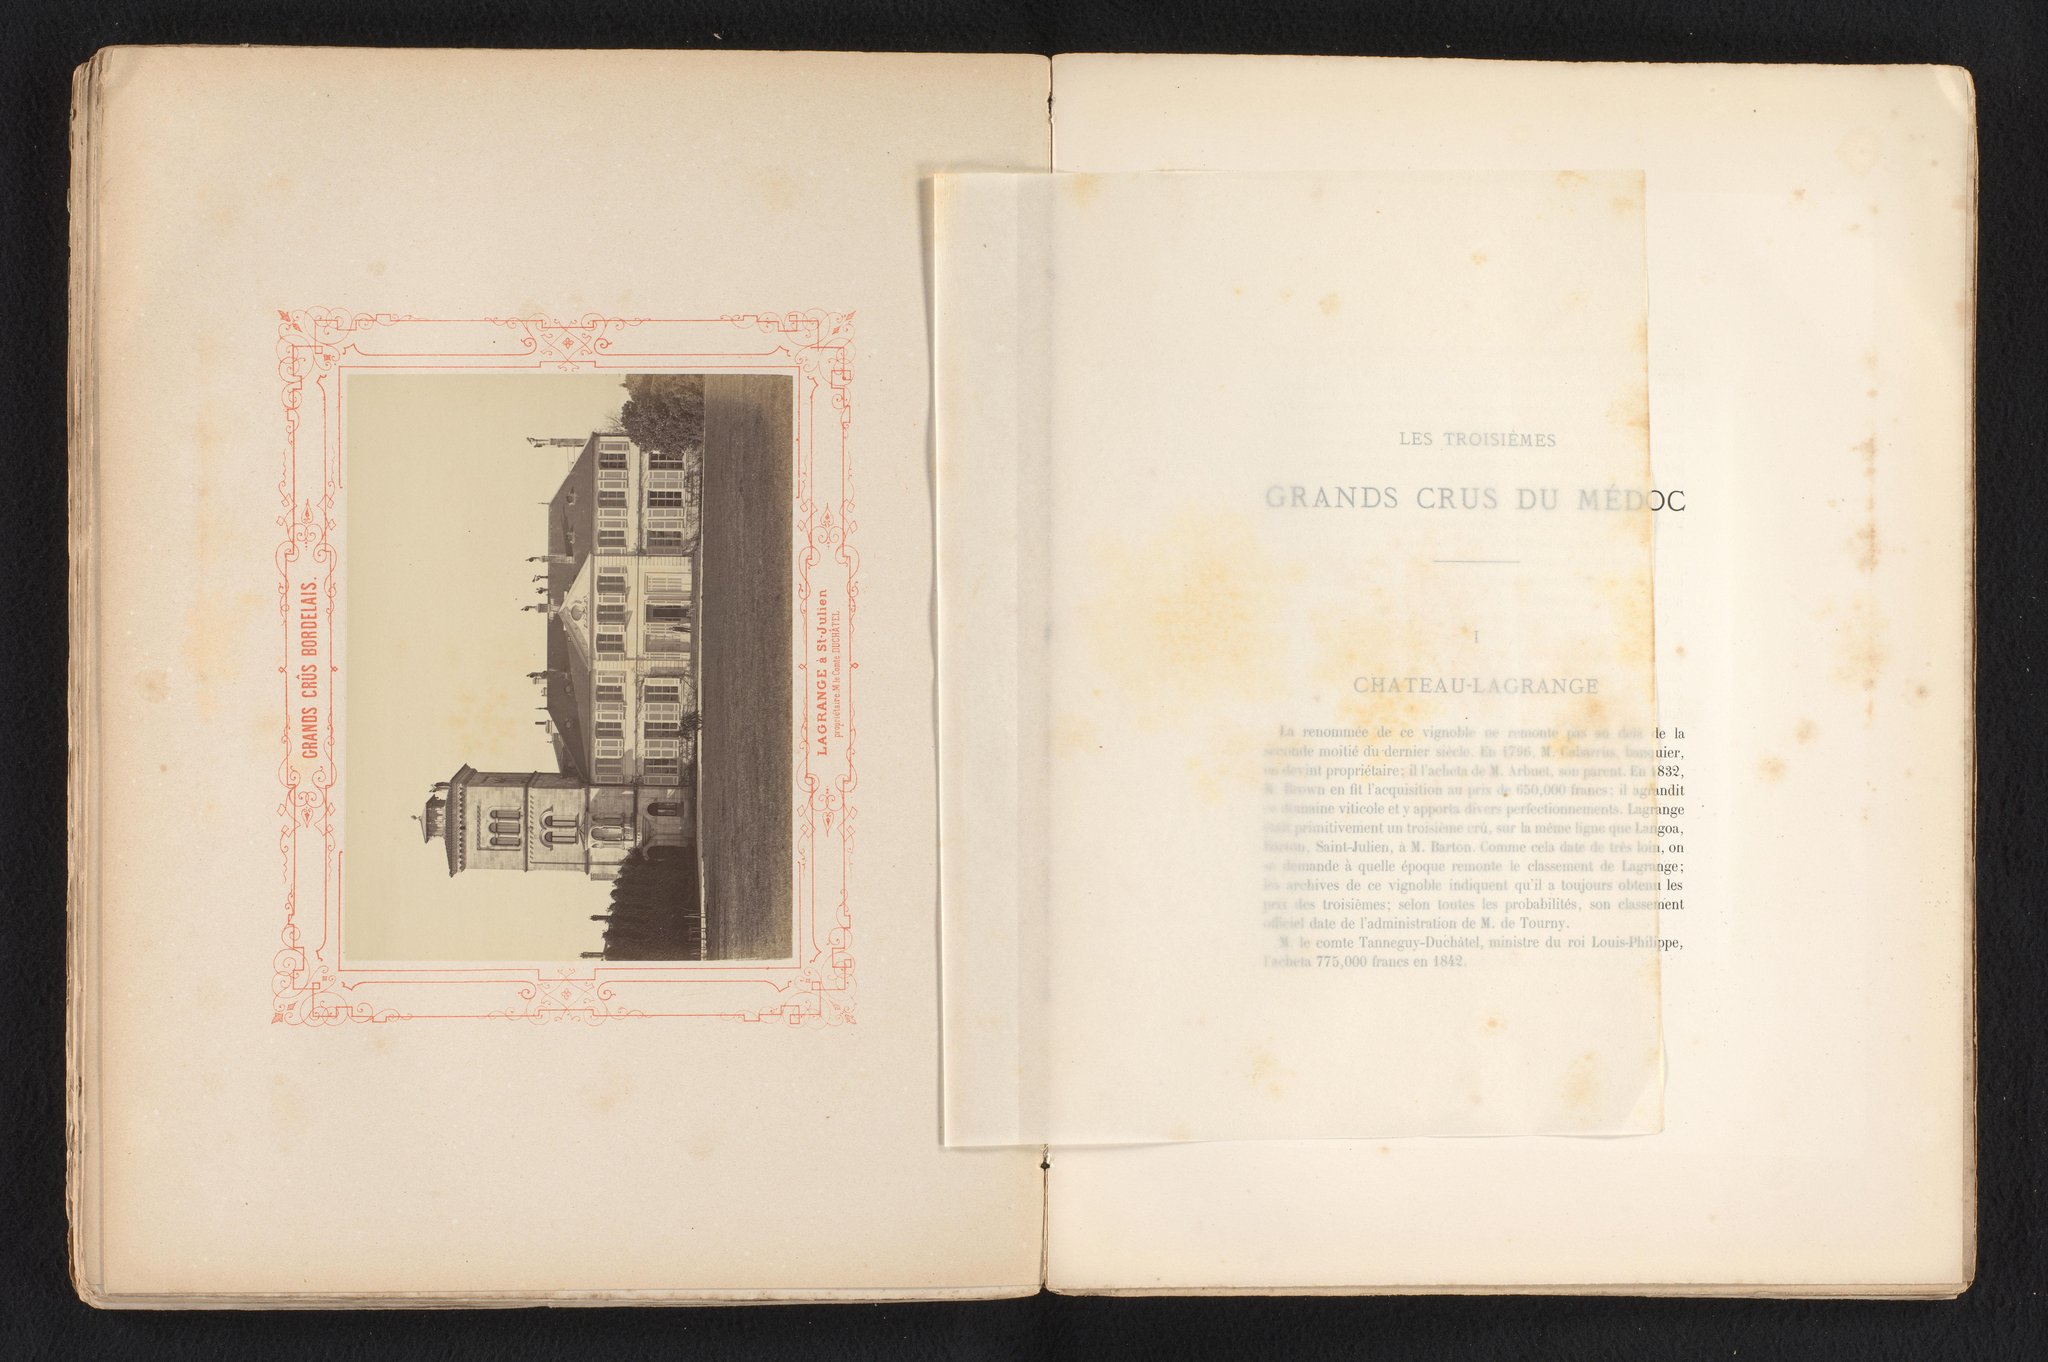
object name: page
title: Grands crûs Bordelais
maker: alfred danflou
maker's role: fotograaf, schrijver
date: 1862-1867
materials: paper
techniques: albumen print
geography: saint-julien-beychevelle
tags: castle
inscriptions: inscription: ‘propriétaire: M. le Come DUCHÂTEL.’